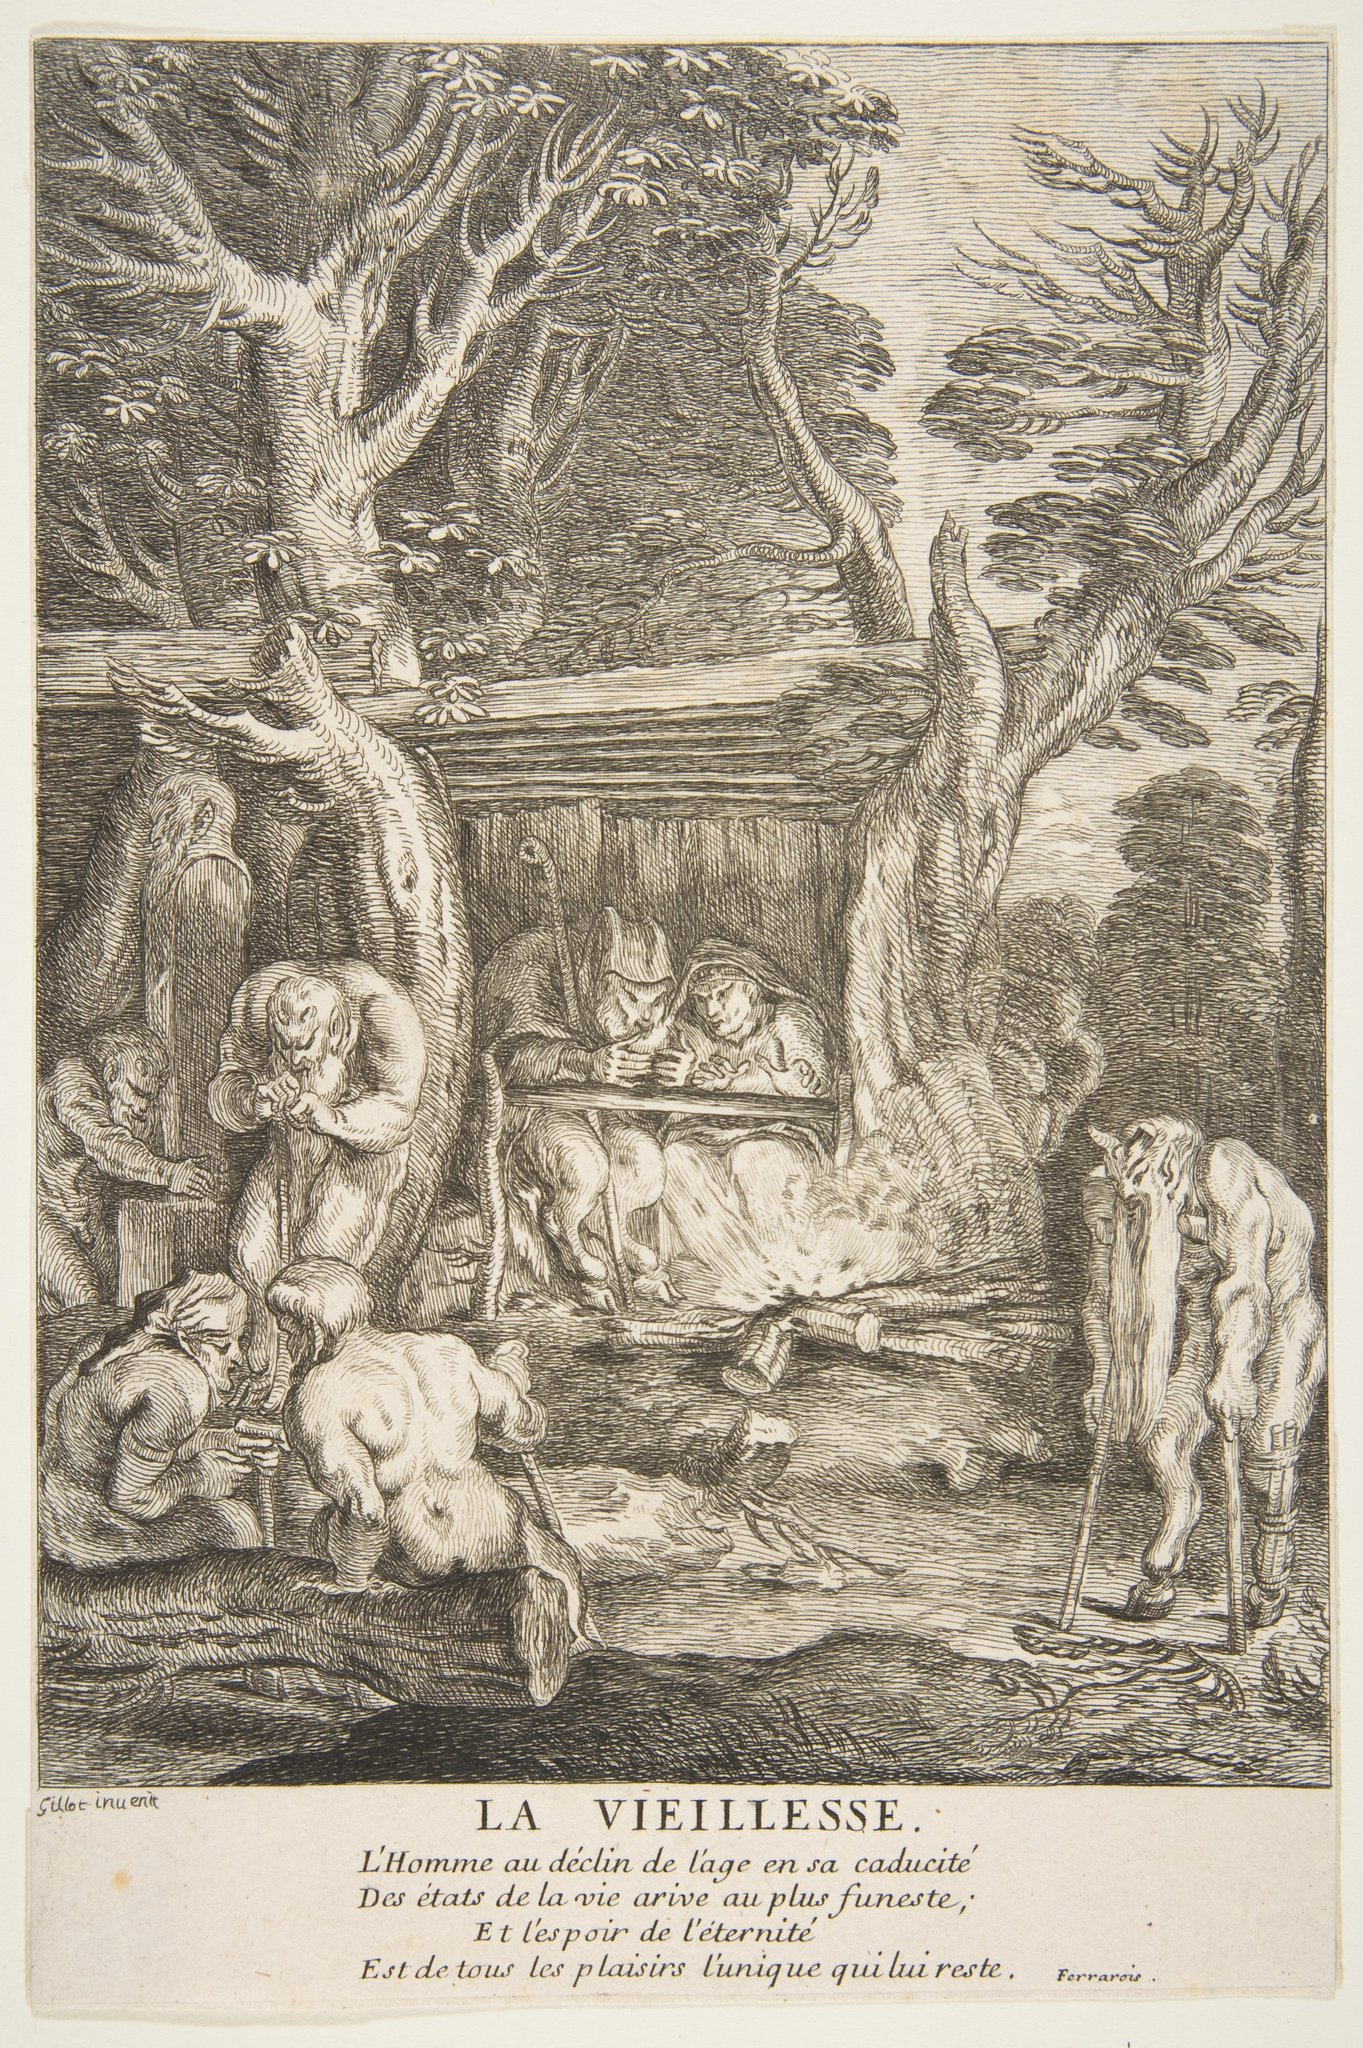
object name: print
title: Old Age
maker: claude gillot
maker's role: artist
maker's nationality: french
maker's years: 1673-1722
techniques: etching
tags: human figures,trees